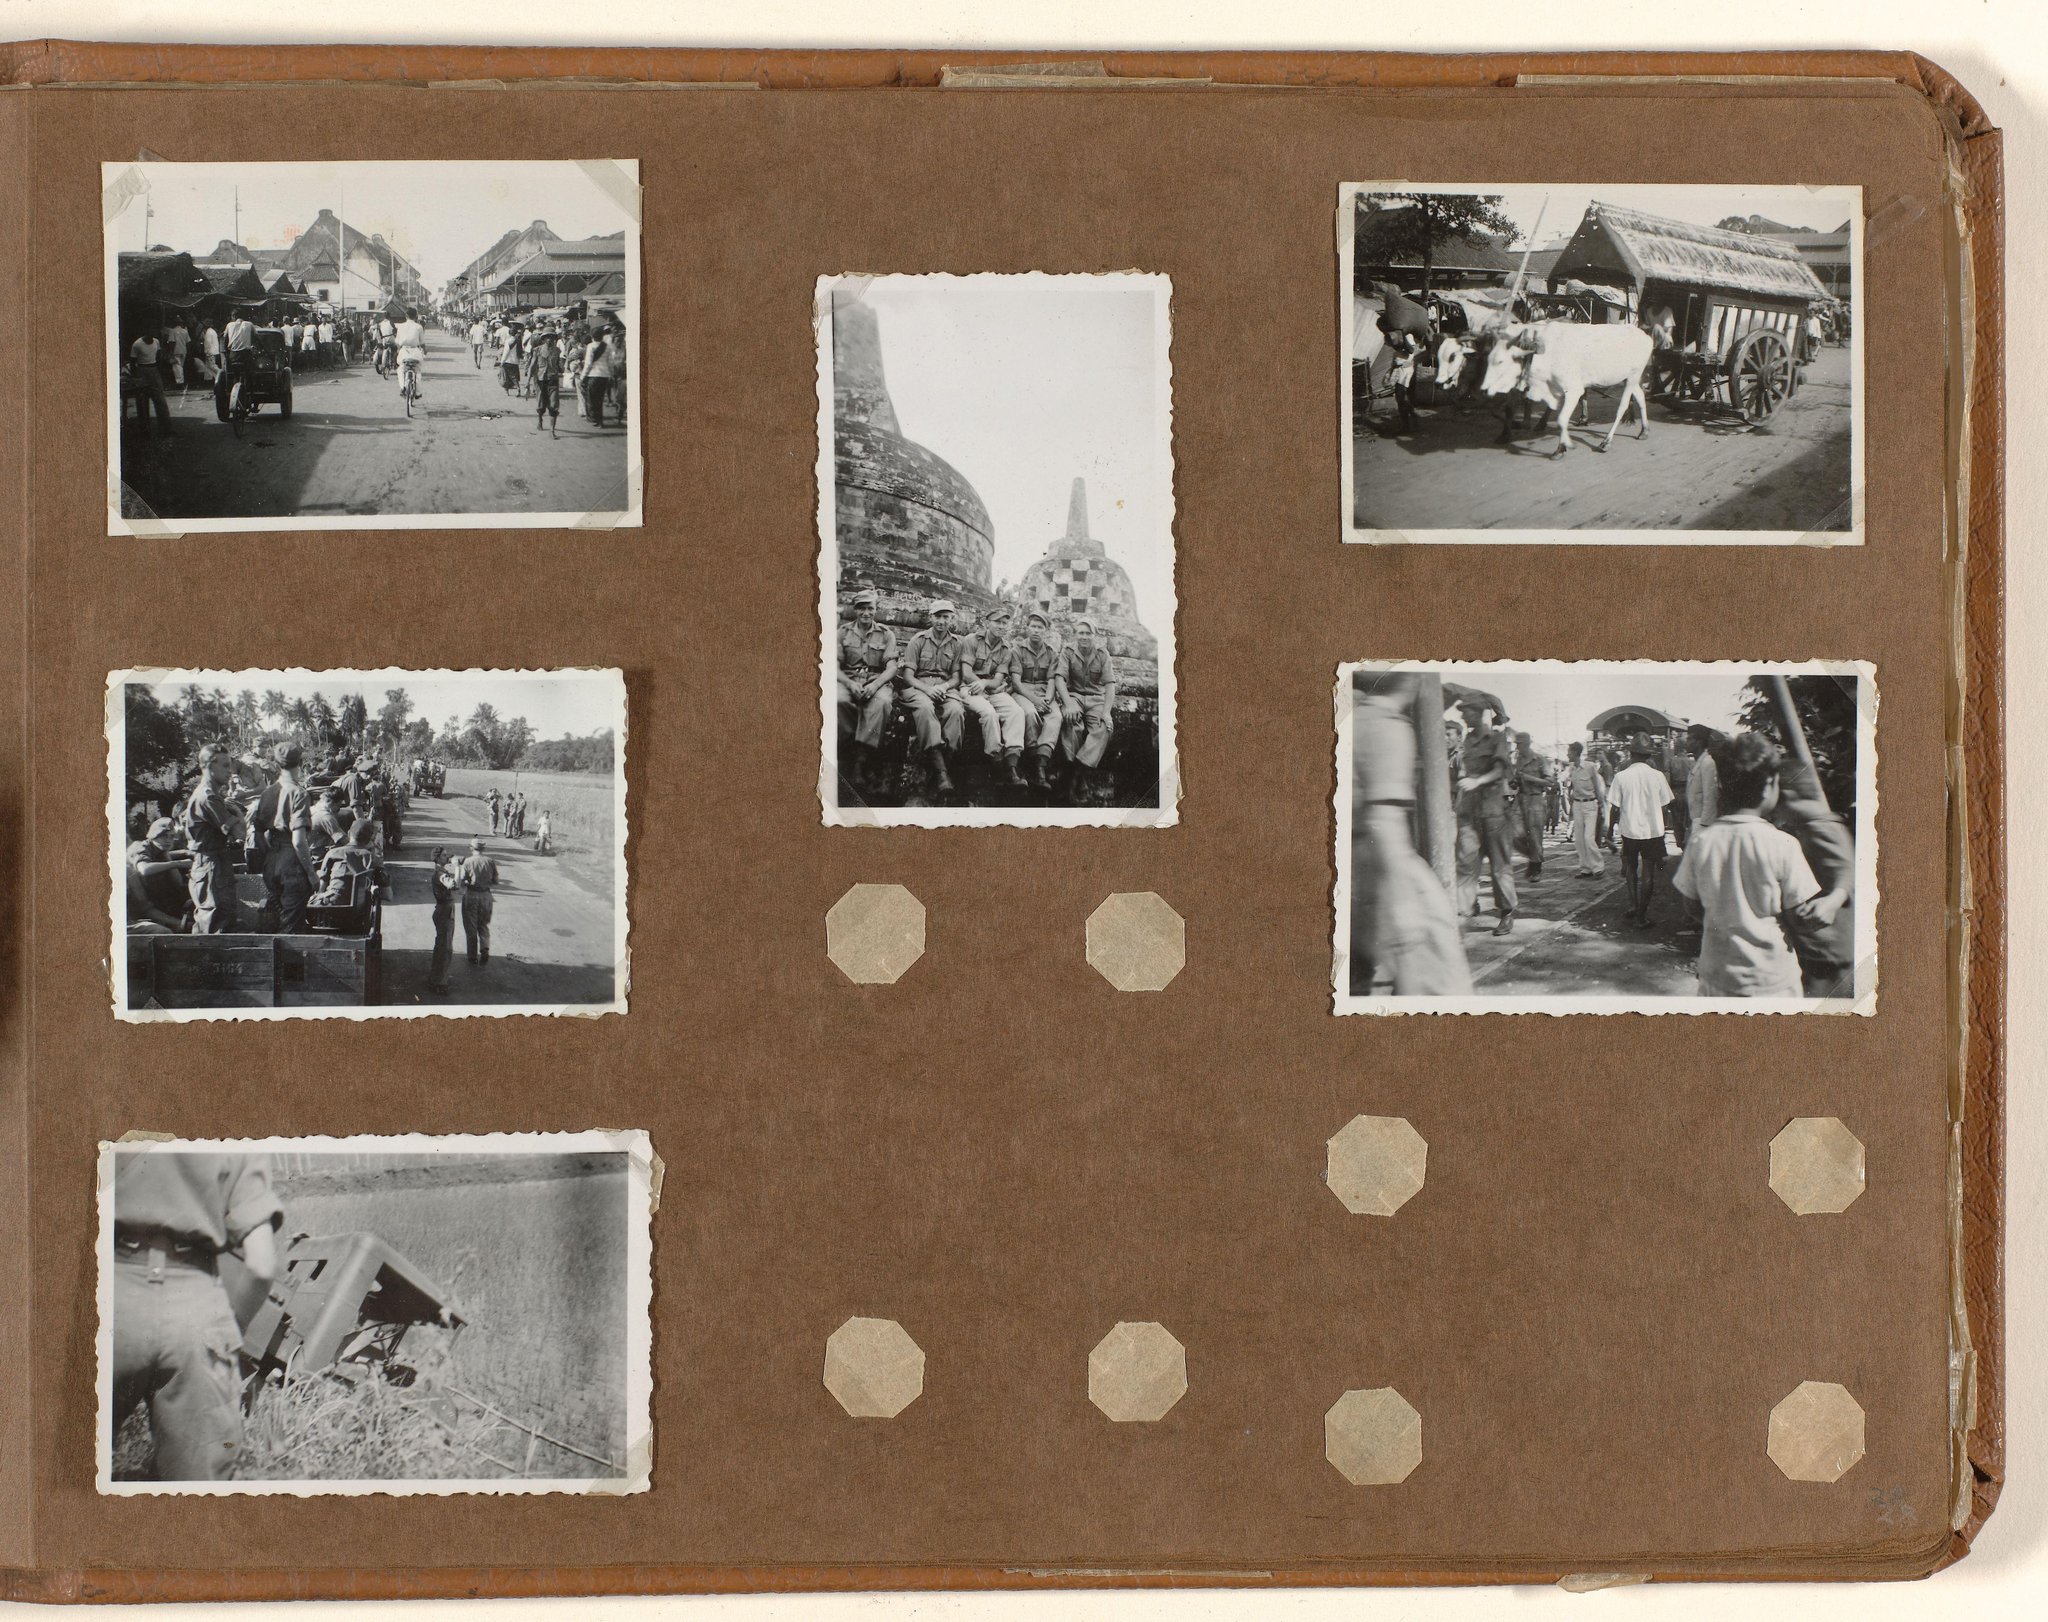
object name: photograph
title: Terugkeer naar Jogyakarta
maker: Anonymous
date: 1949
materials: paper, photographic support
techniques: photography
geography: jogjakarta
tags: outing, pleasure trip, the soldier off duty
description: Albumblad met zes foto's die waarschijnlijk de opmars naar Jogyakarta laten zien. De foto's betreffen een militaire colonne met wagens onderweg, een wagen die van de weg is geraakt, een ossenwagen, militairen bij een trein, een straatbeeld van Semarang of Jogyakarta en het tempelcomplex Borobudur met vier soldaten die op de trap van een stoepa poseren.